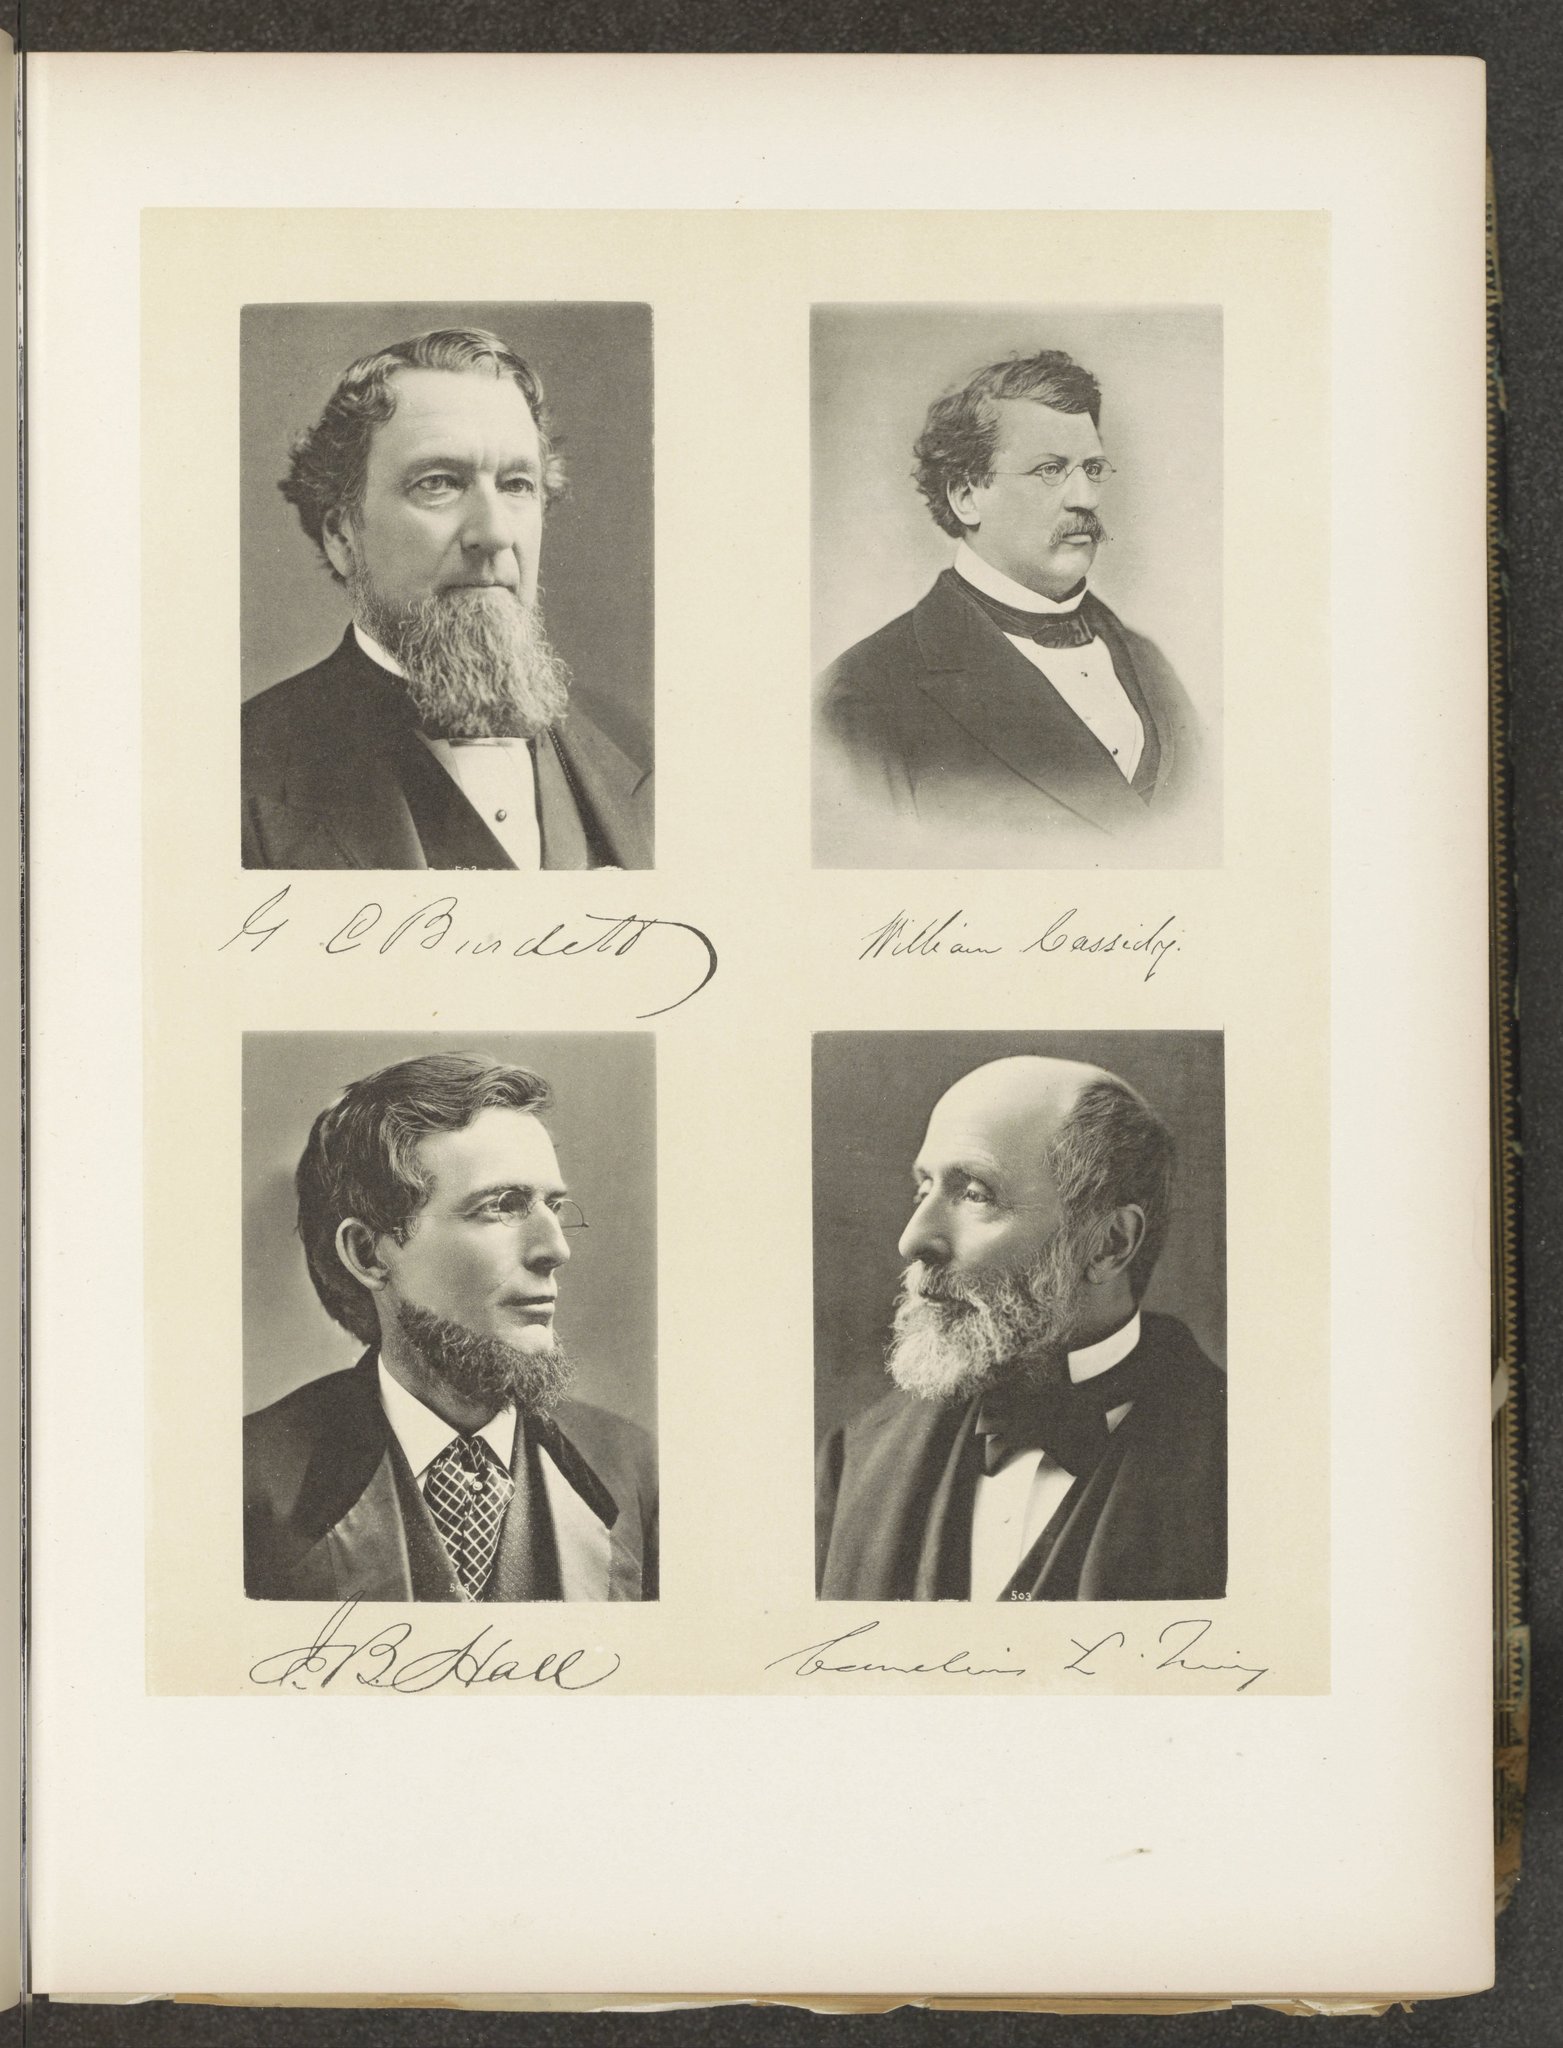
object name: page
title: Vier portretten van leden van de Constitutionele Commissie van de staat New York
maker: Anonymous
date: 1872-1882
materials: paper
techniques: photograph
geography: united states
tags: historical persons (+ head (and shoulders) (portrait))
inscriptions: annotation, number: ‘503’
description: Linksboven George C. Burdett, rechtsboven William Cassidy, linksonder Joseph B. Hall, rechtsonder Cornelius L. Tracy.